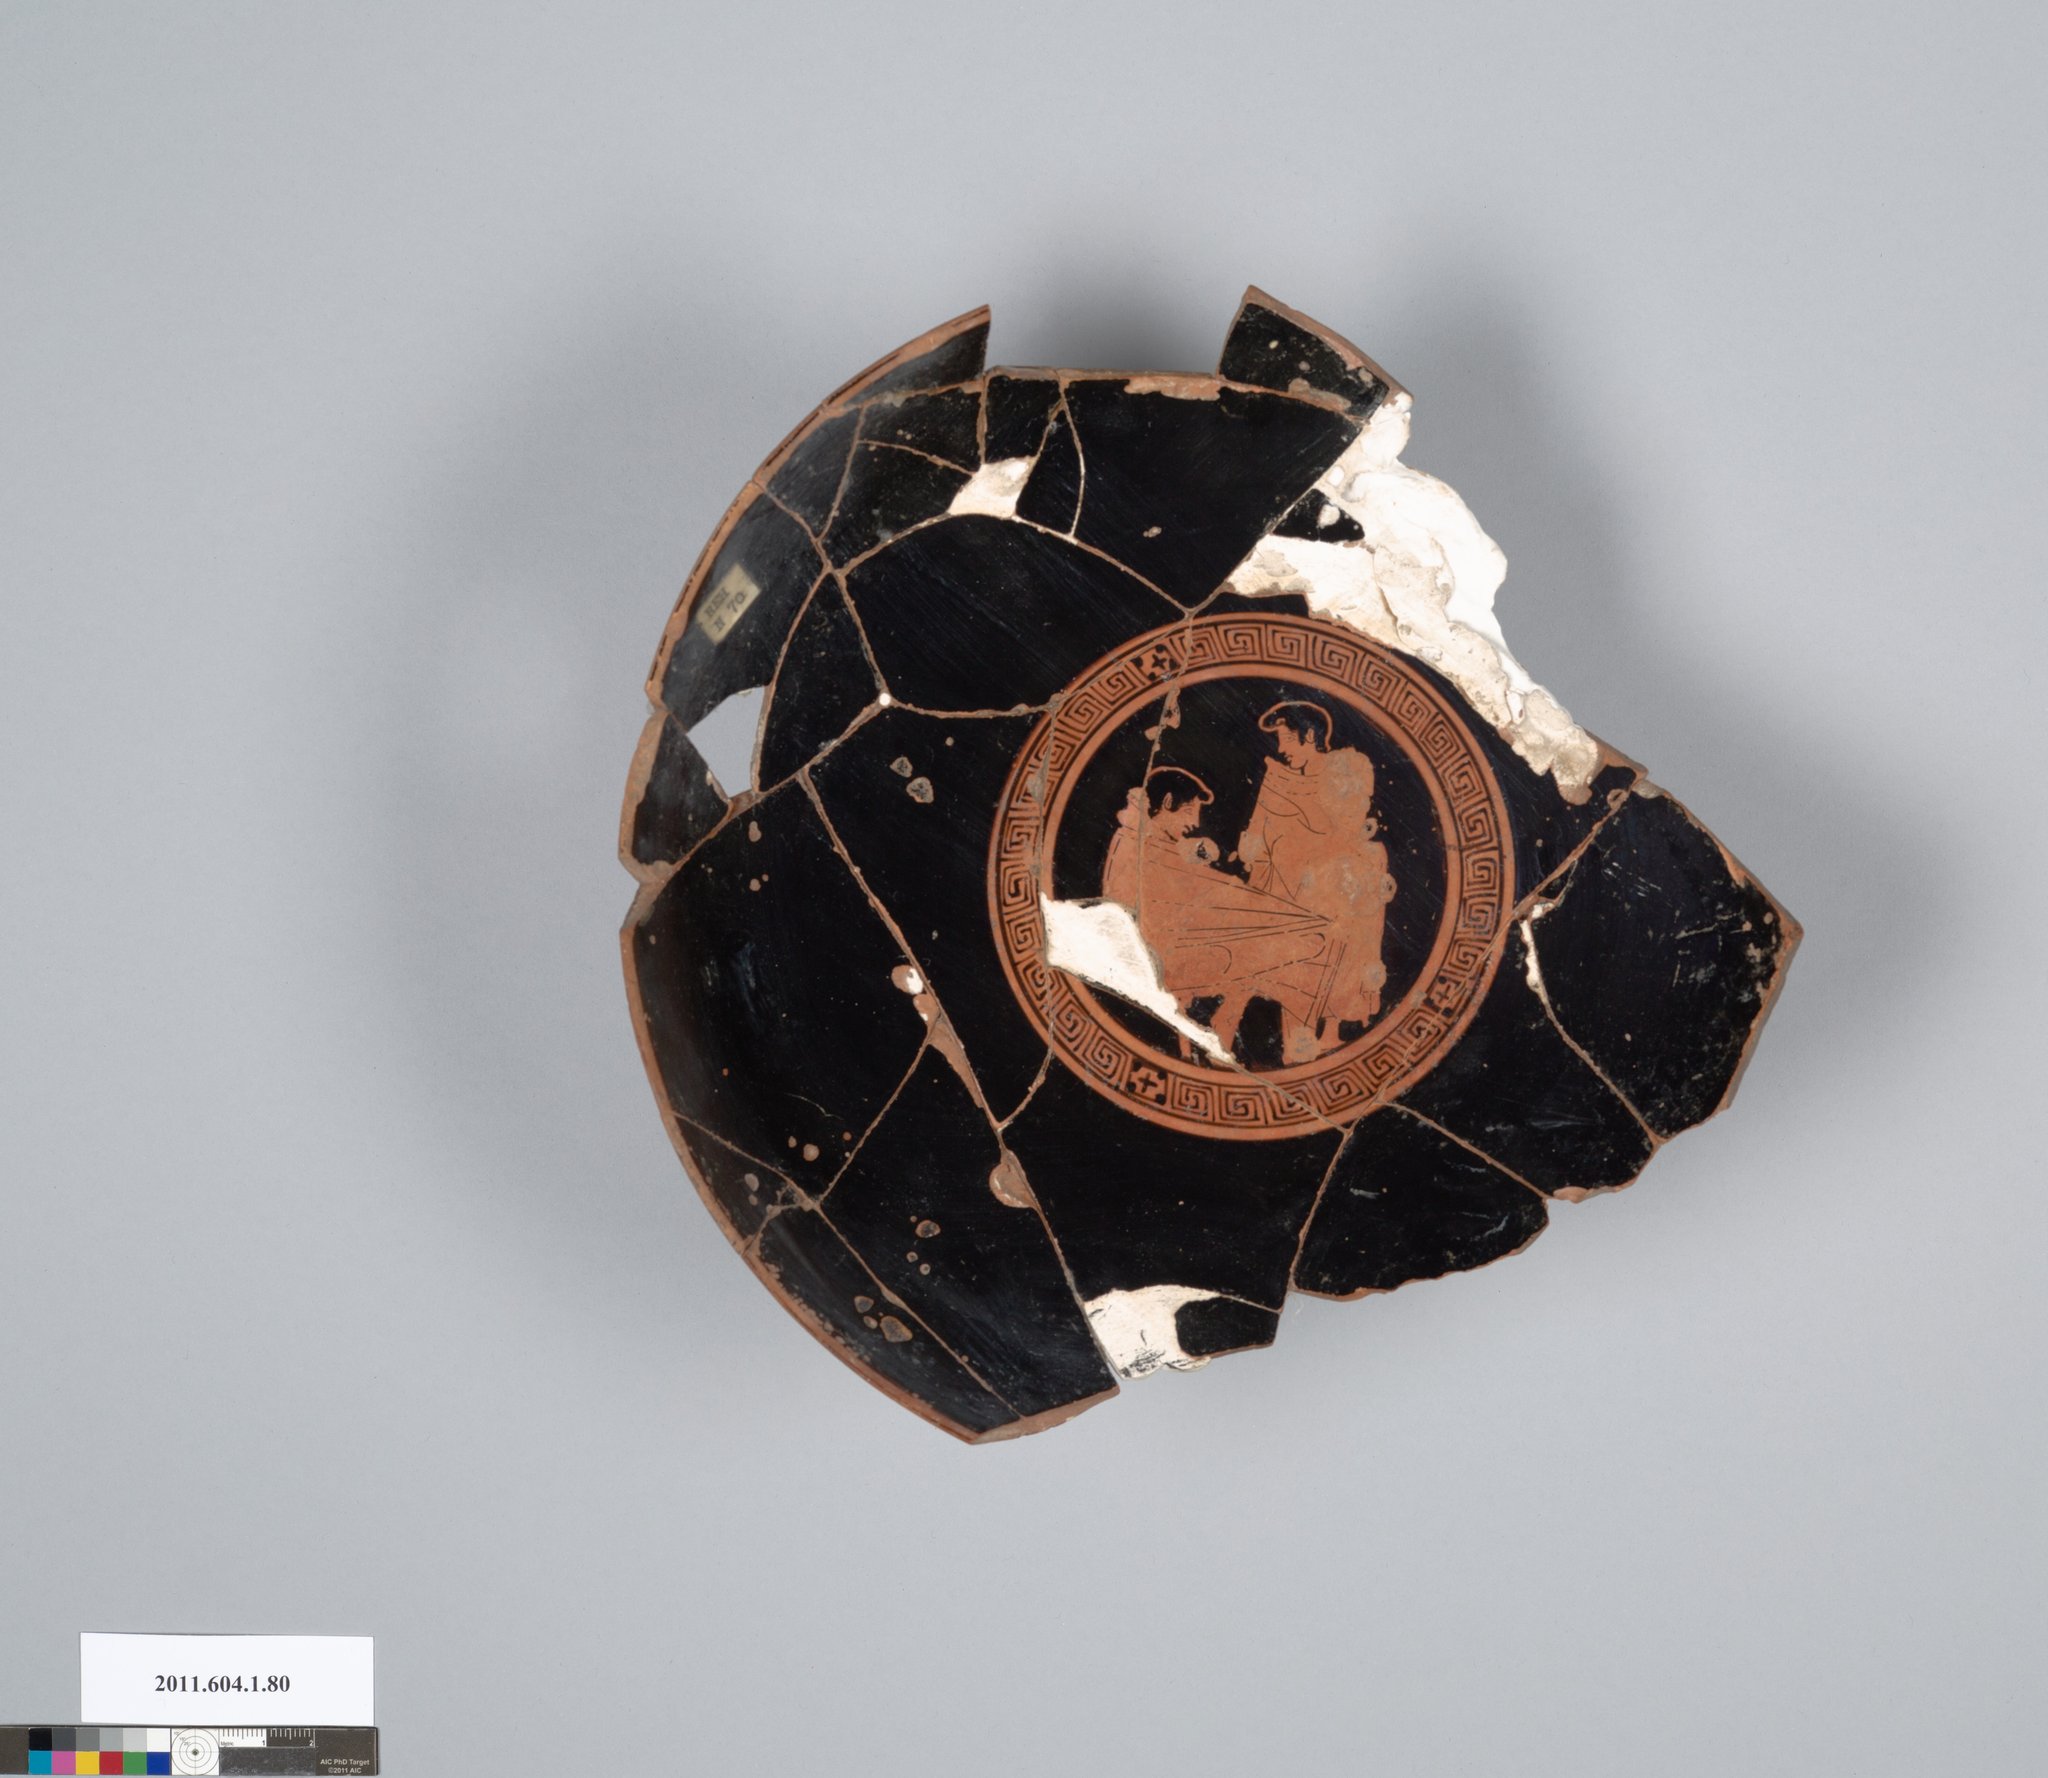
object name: kylix fragment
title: Terracotta fragment of a kylix (drinking cup)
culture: greek, attic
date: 467-435 BCE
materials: terracotta